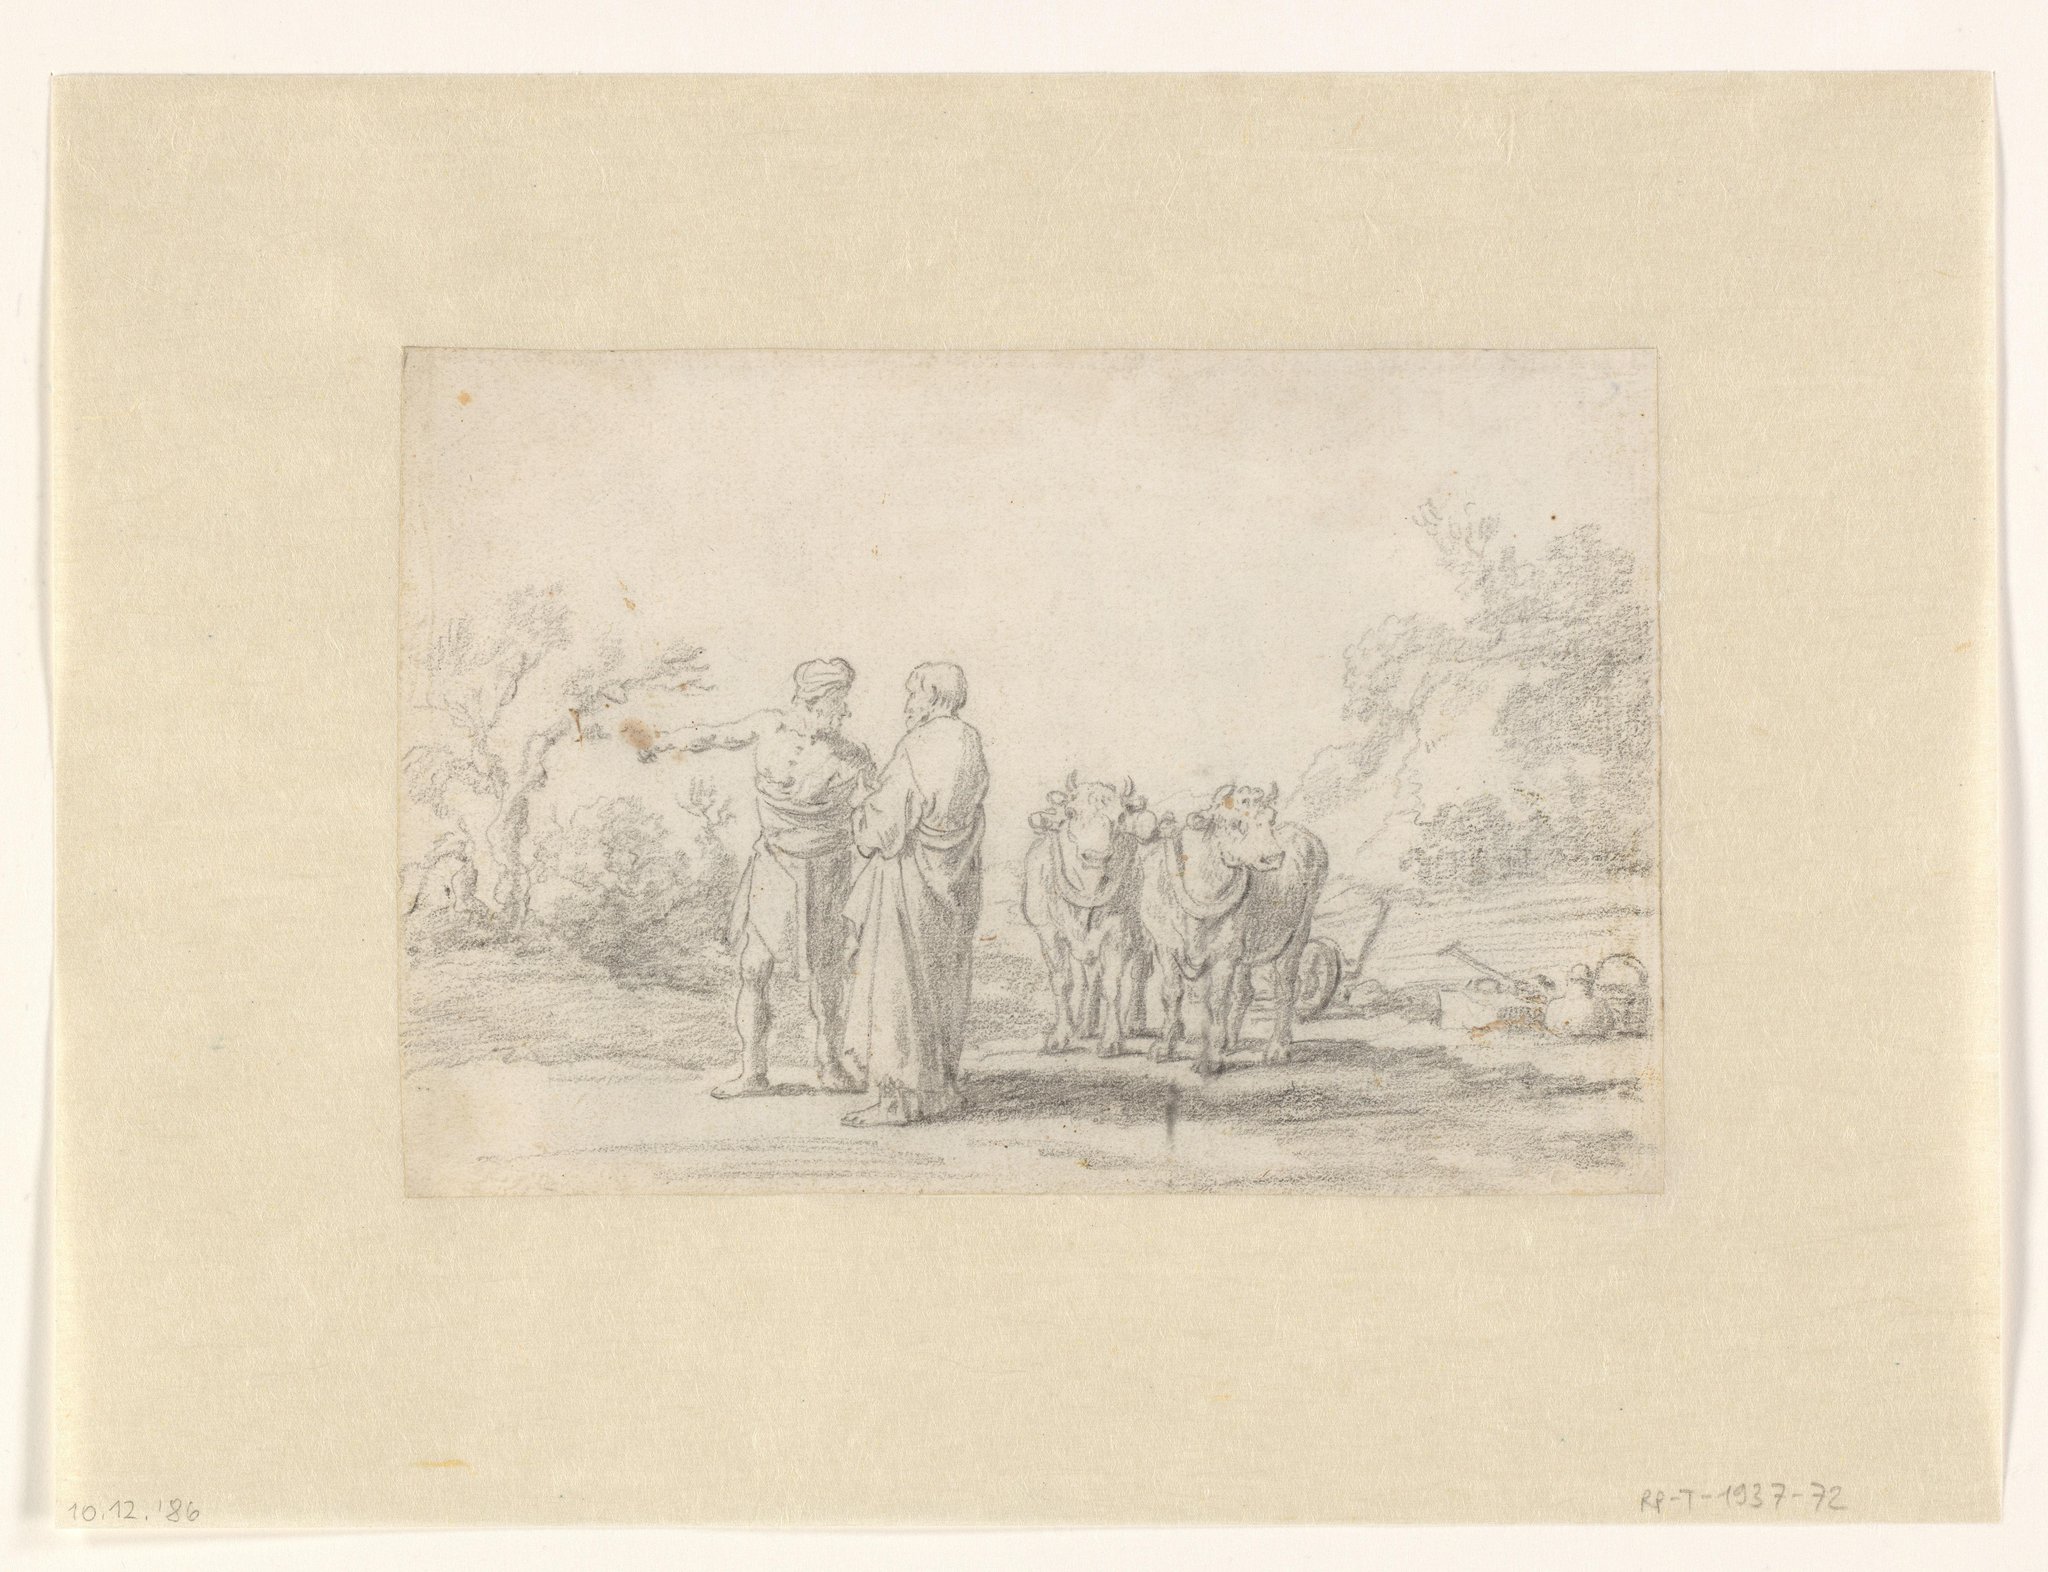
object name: drawing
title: Lucius Quintius Cincinnatus Leaving his Plough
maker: claes moeyaert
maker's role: draughtsman, painter, print maker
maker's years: 1592-1655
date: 1628-1632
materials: chalk, paper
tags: lucius quinctius cincinnatus is called from the plough to the dictatorship of rome; a roman embassy offers him a sword or a baton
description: In this scene, a senator is prevailing upon the Roman general Cincinnatus to leave his ox plough and come to the rescue of Rome, which was engaged in a disastrous war. According to the Roman historian Livy, Cincinnatus – the paragon of a virtuous leader – relinquished his newly acquired power immediately after the Roman victory in order to return to his farm.